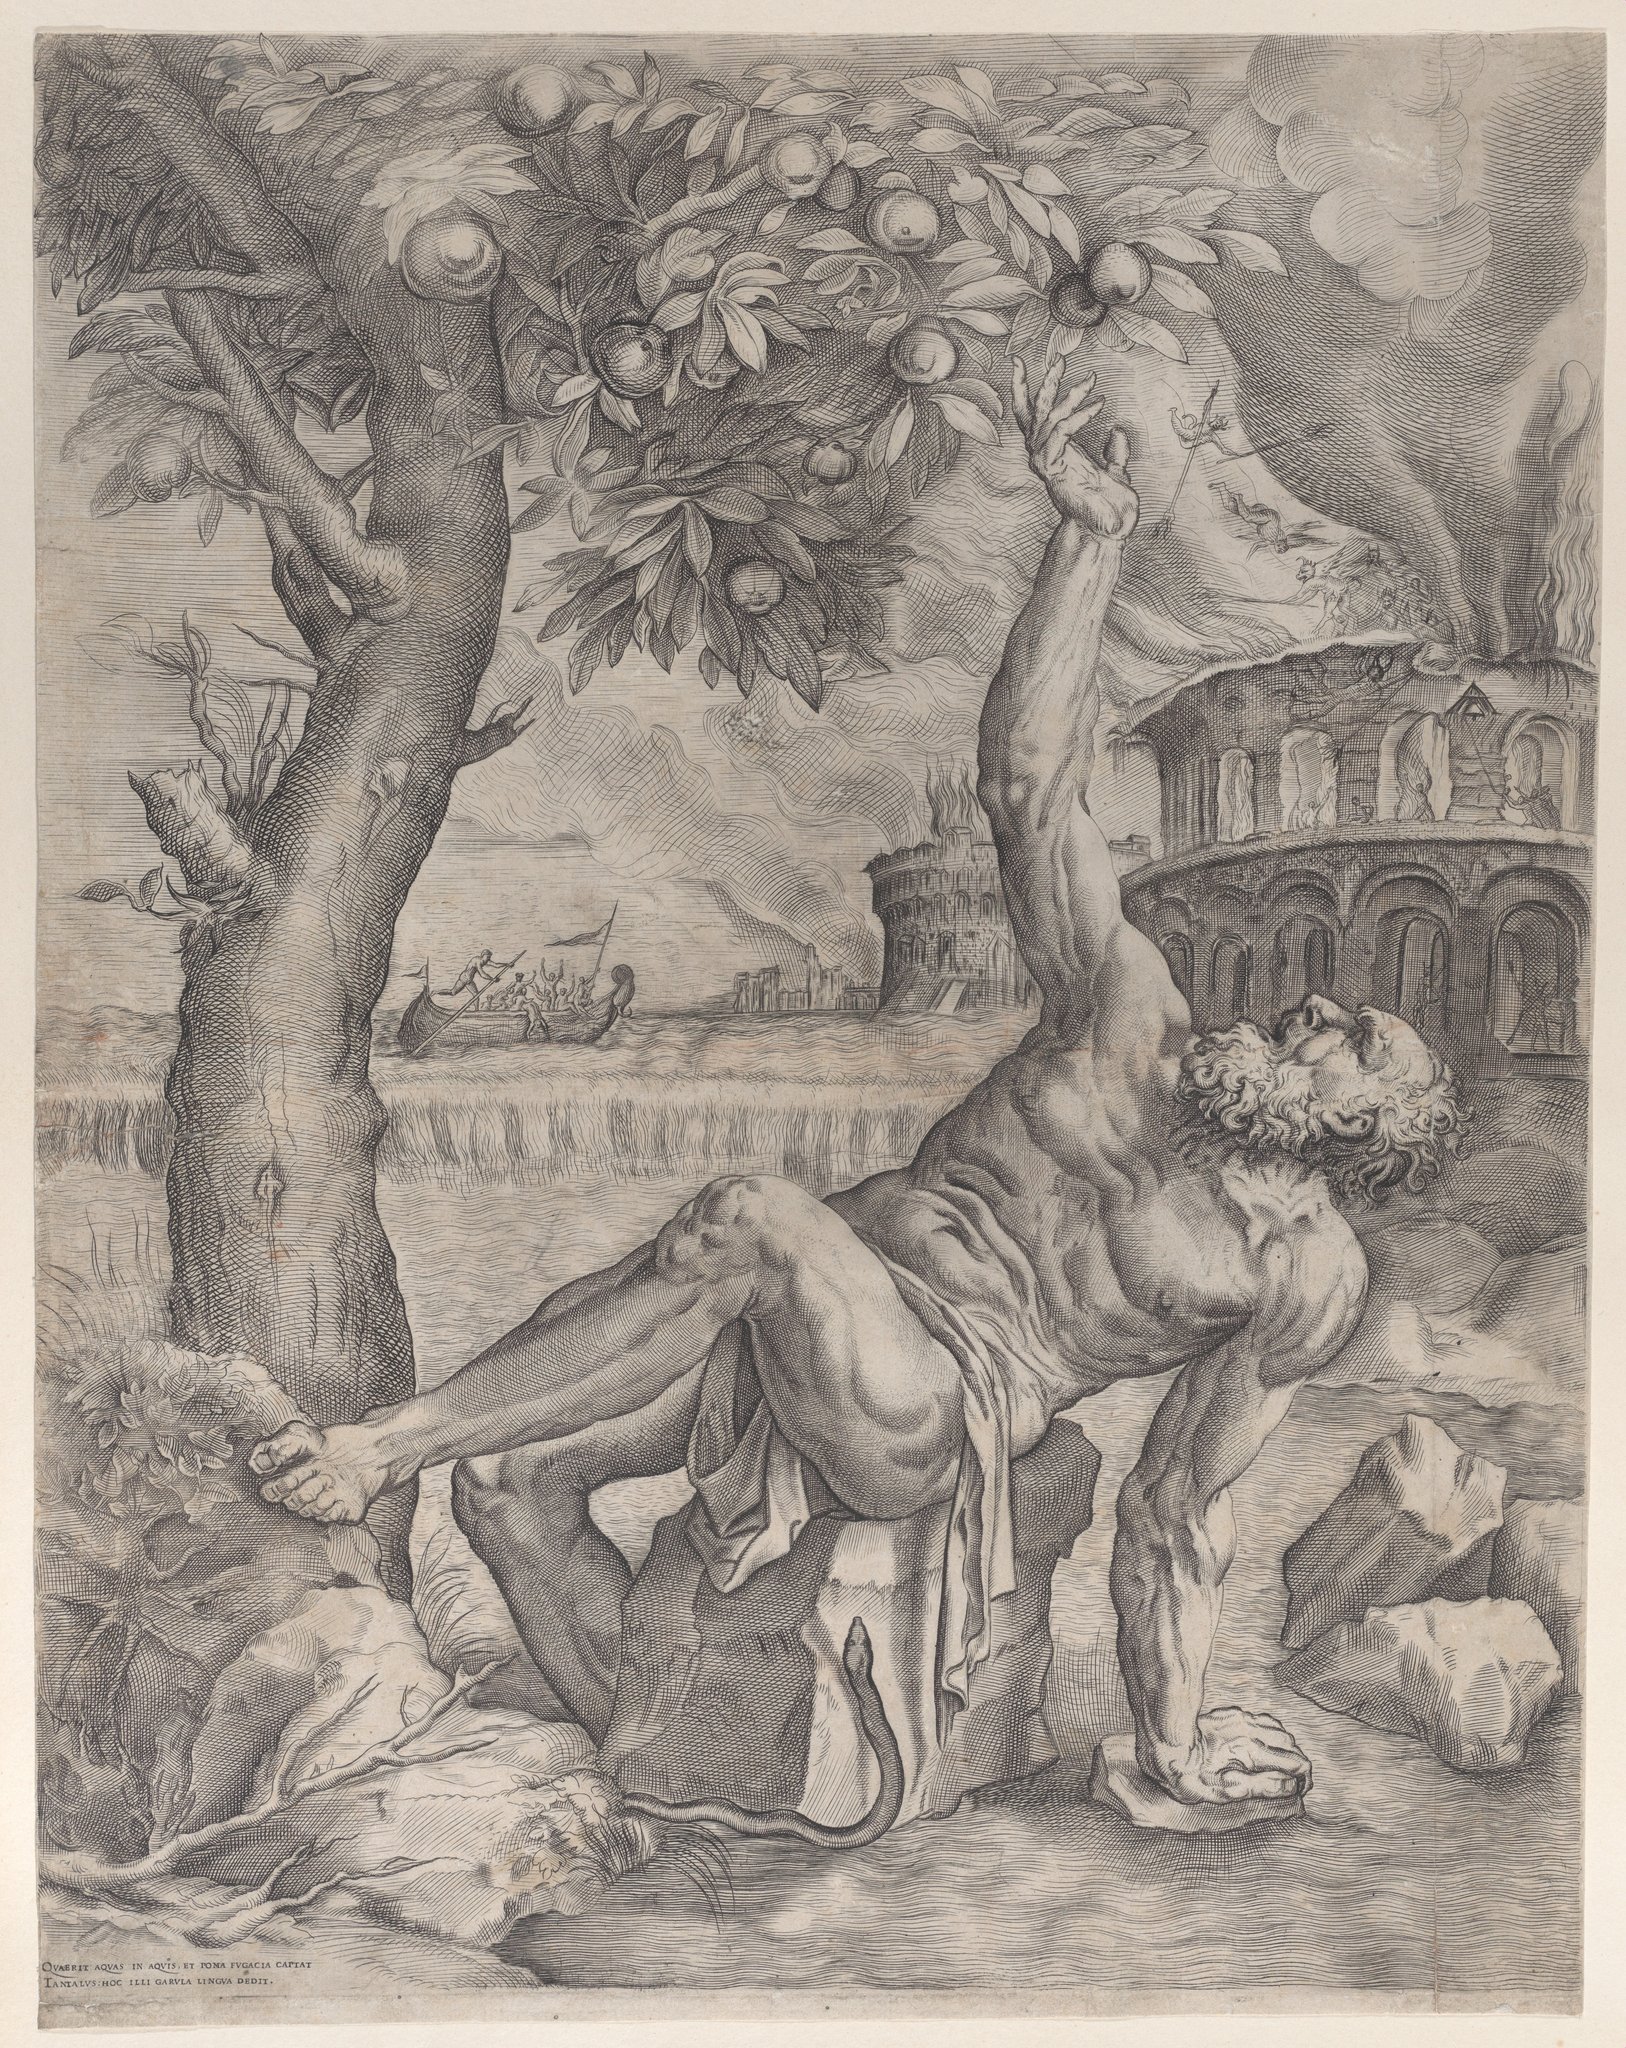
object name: print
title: Tantalus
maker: giulio sanuto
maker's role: artist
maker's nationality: italian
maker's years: 1540-1588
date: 1557-1570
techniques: engraving